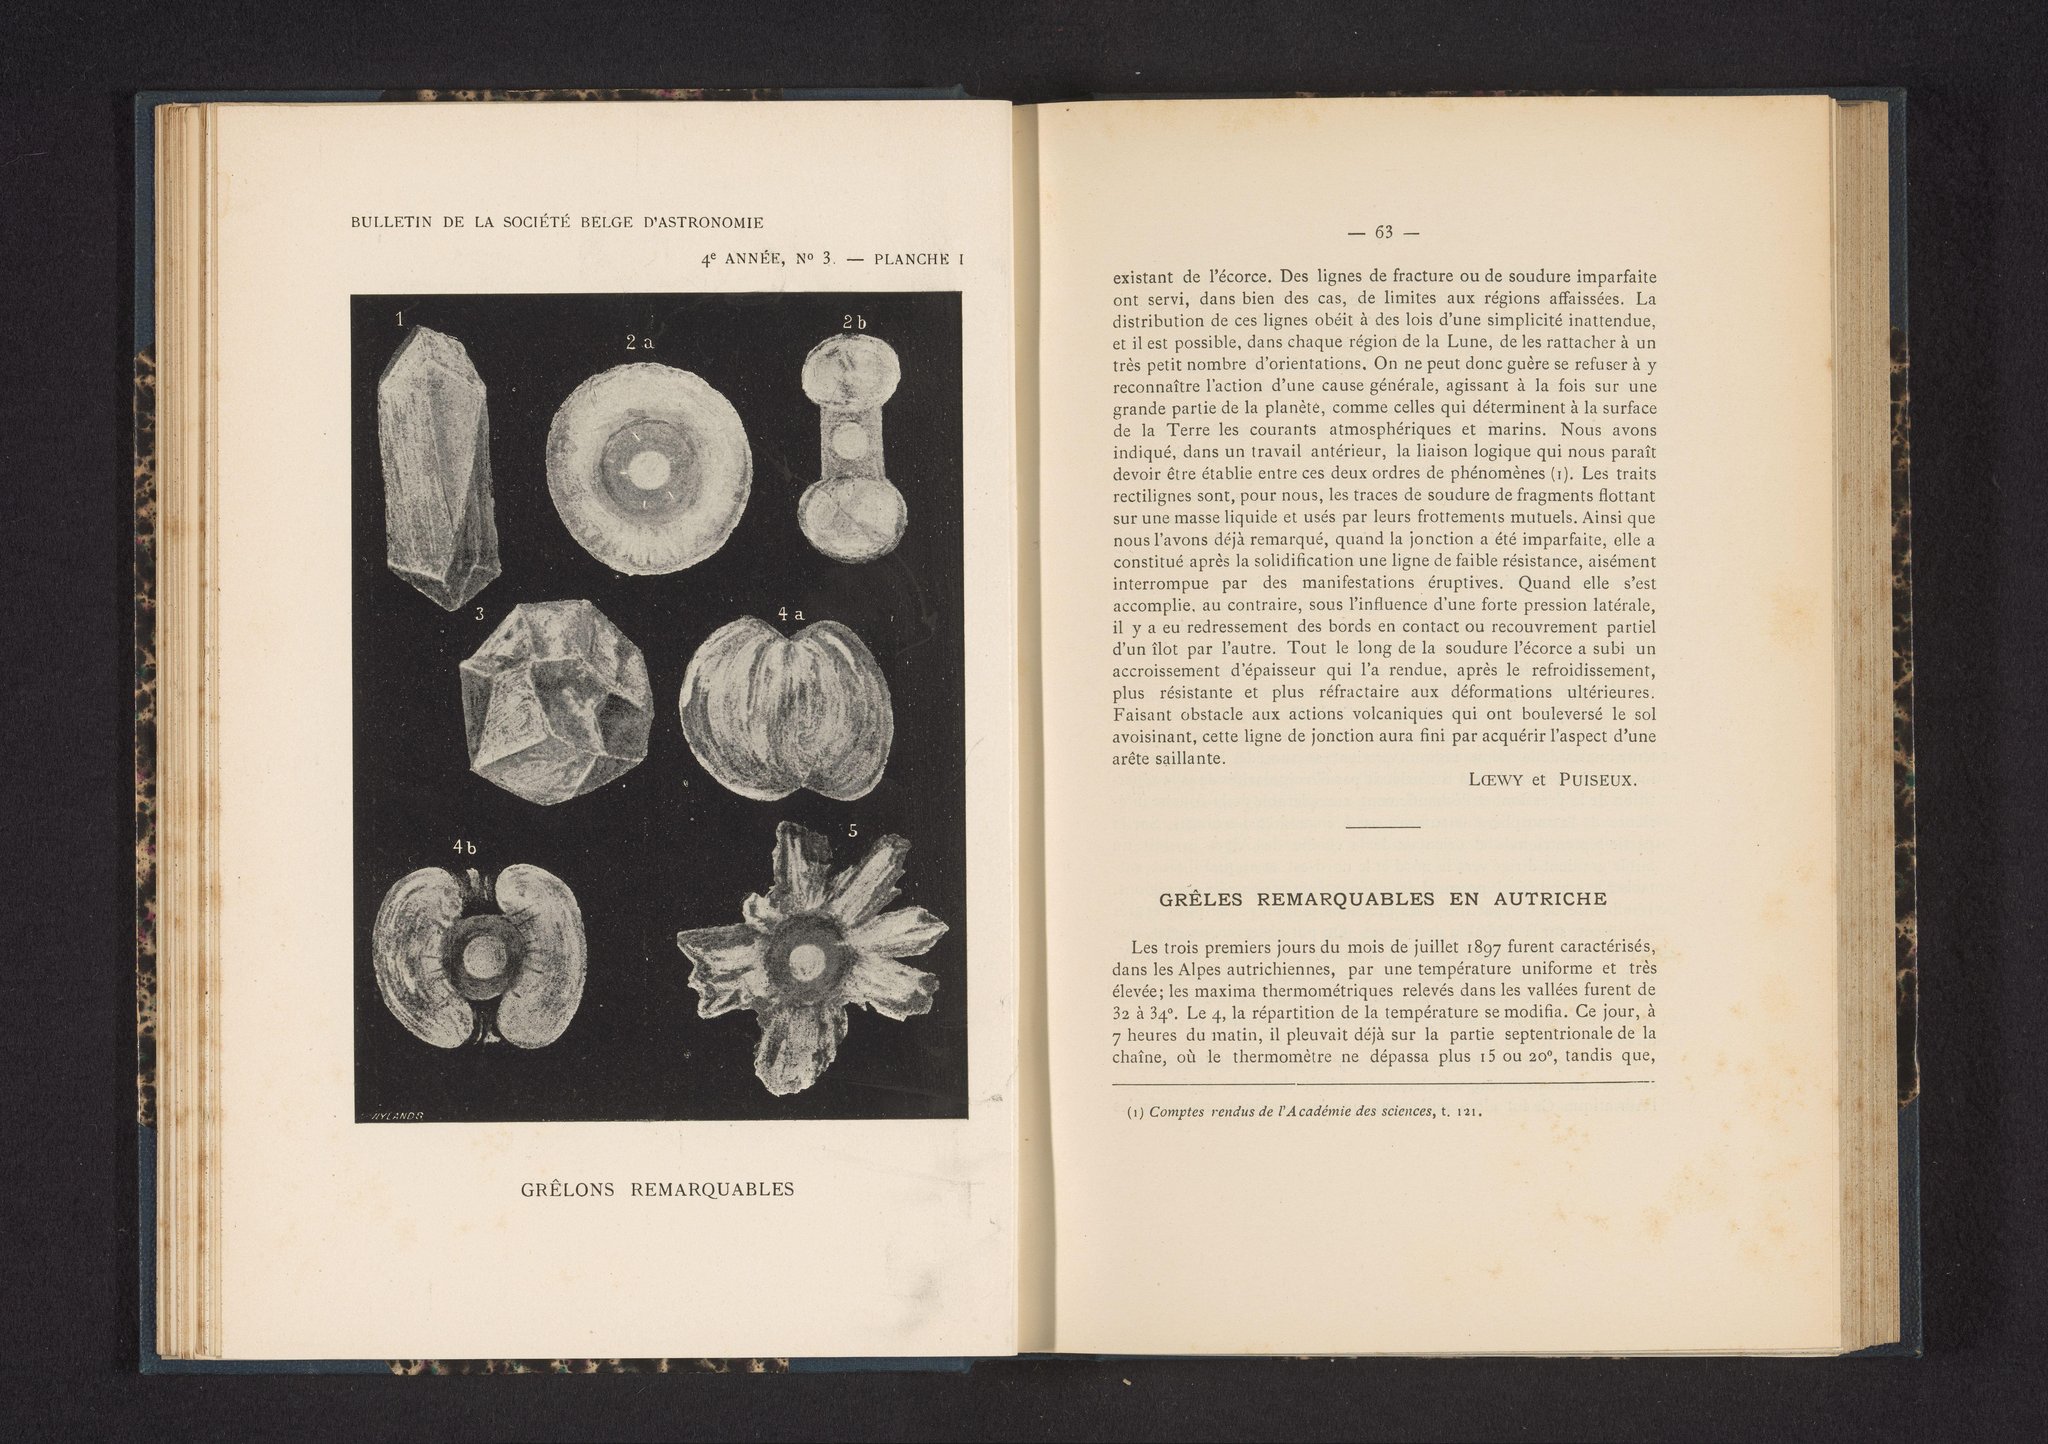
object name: photomechanical print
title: Grêlons remarquables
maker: Anonymous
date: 1894-1899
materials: paper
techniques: autotype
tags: hail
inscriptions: inscription: ‘4e Année, No 3. - Planche I’